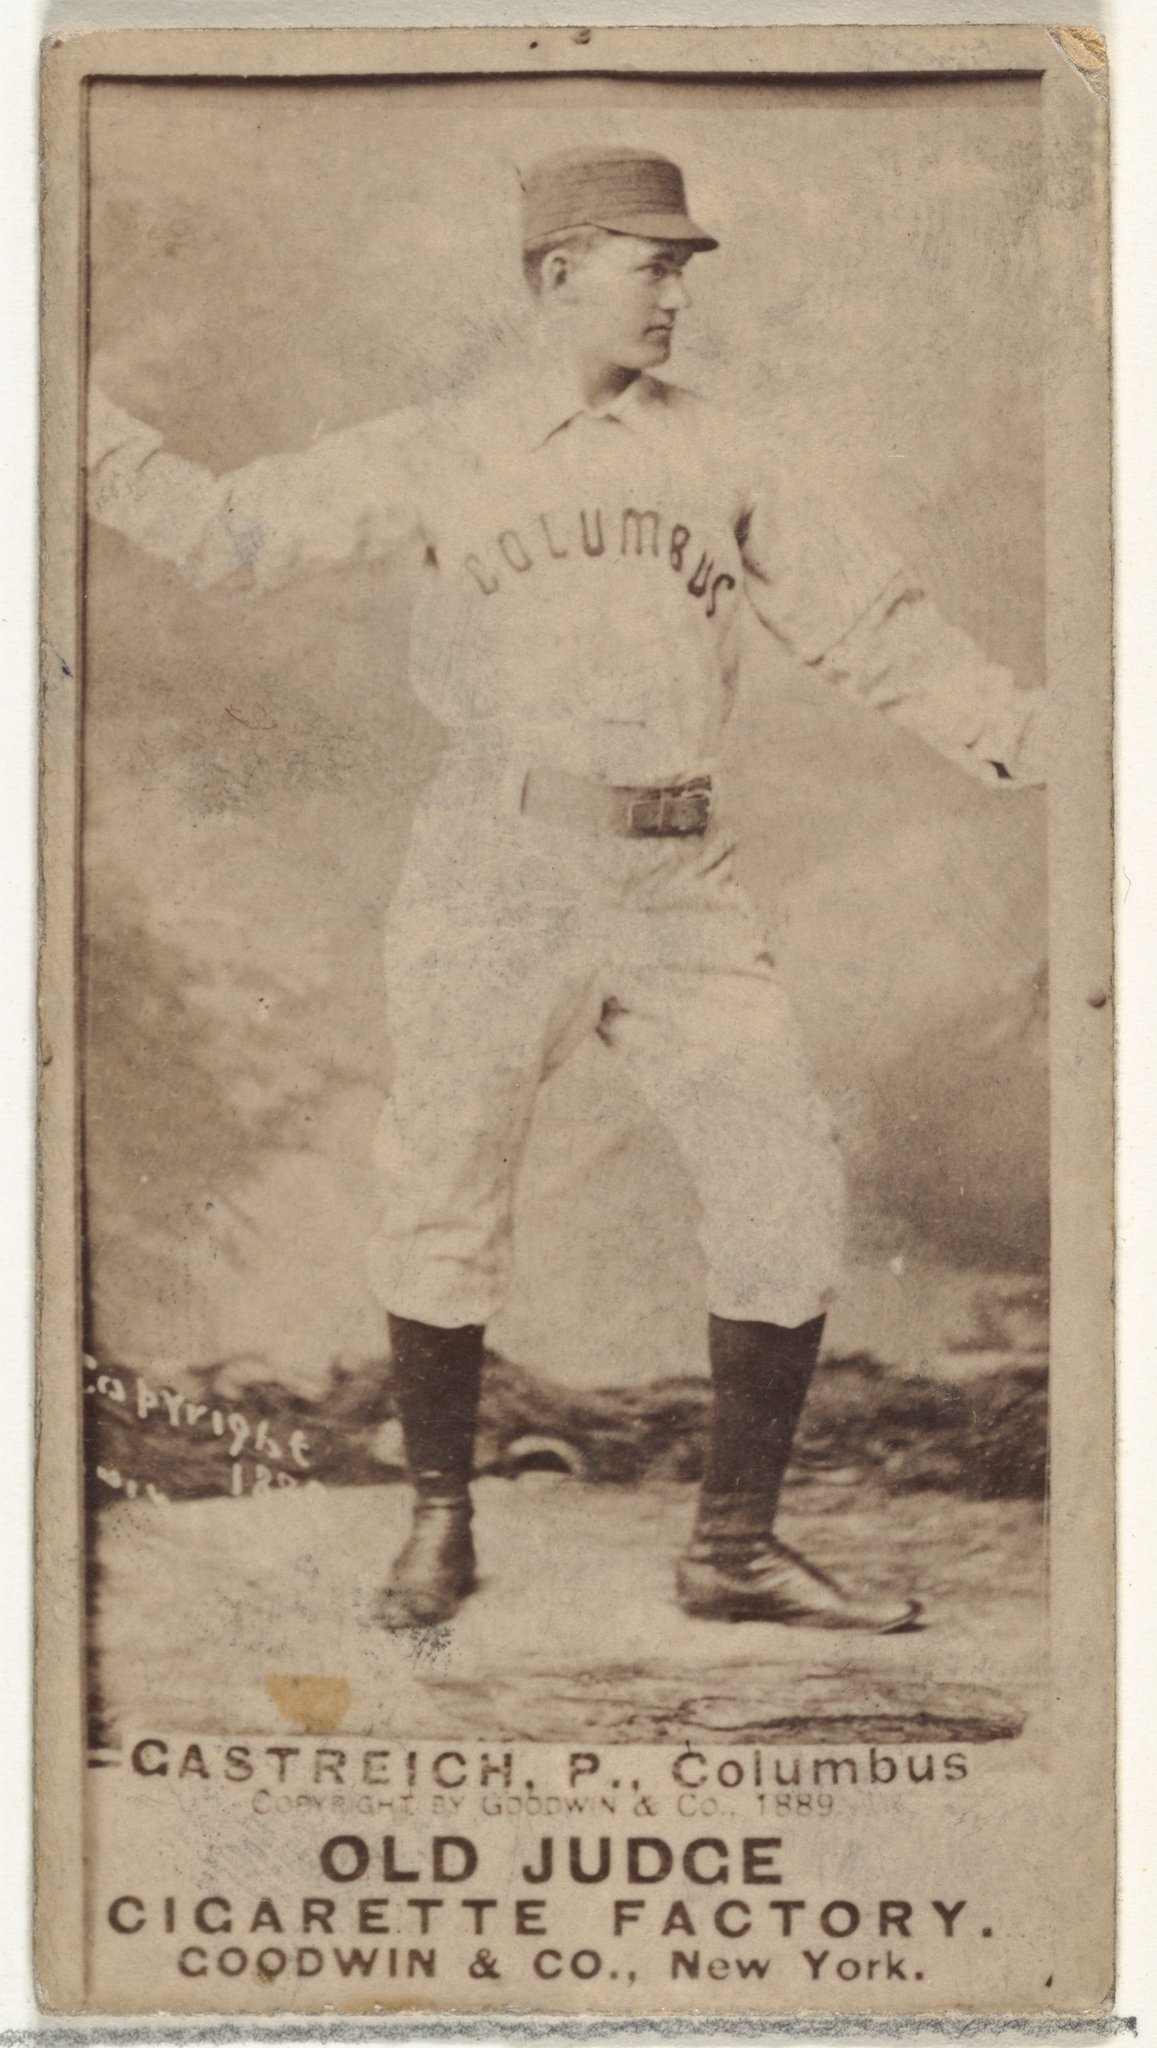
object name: baseball card, photograph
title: Henry Carl "Hank" Gastright, Pitcher, Cleveland, from the Old Judge series (N172) for Old Judge Cigarettes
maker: goodwin & company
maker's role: publisher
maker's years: 1850-1950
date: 1889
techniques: albumen silver print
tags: men,baseball,athletes